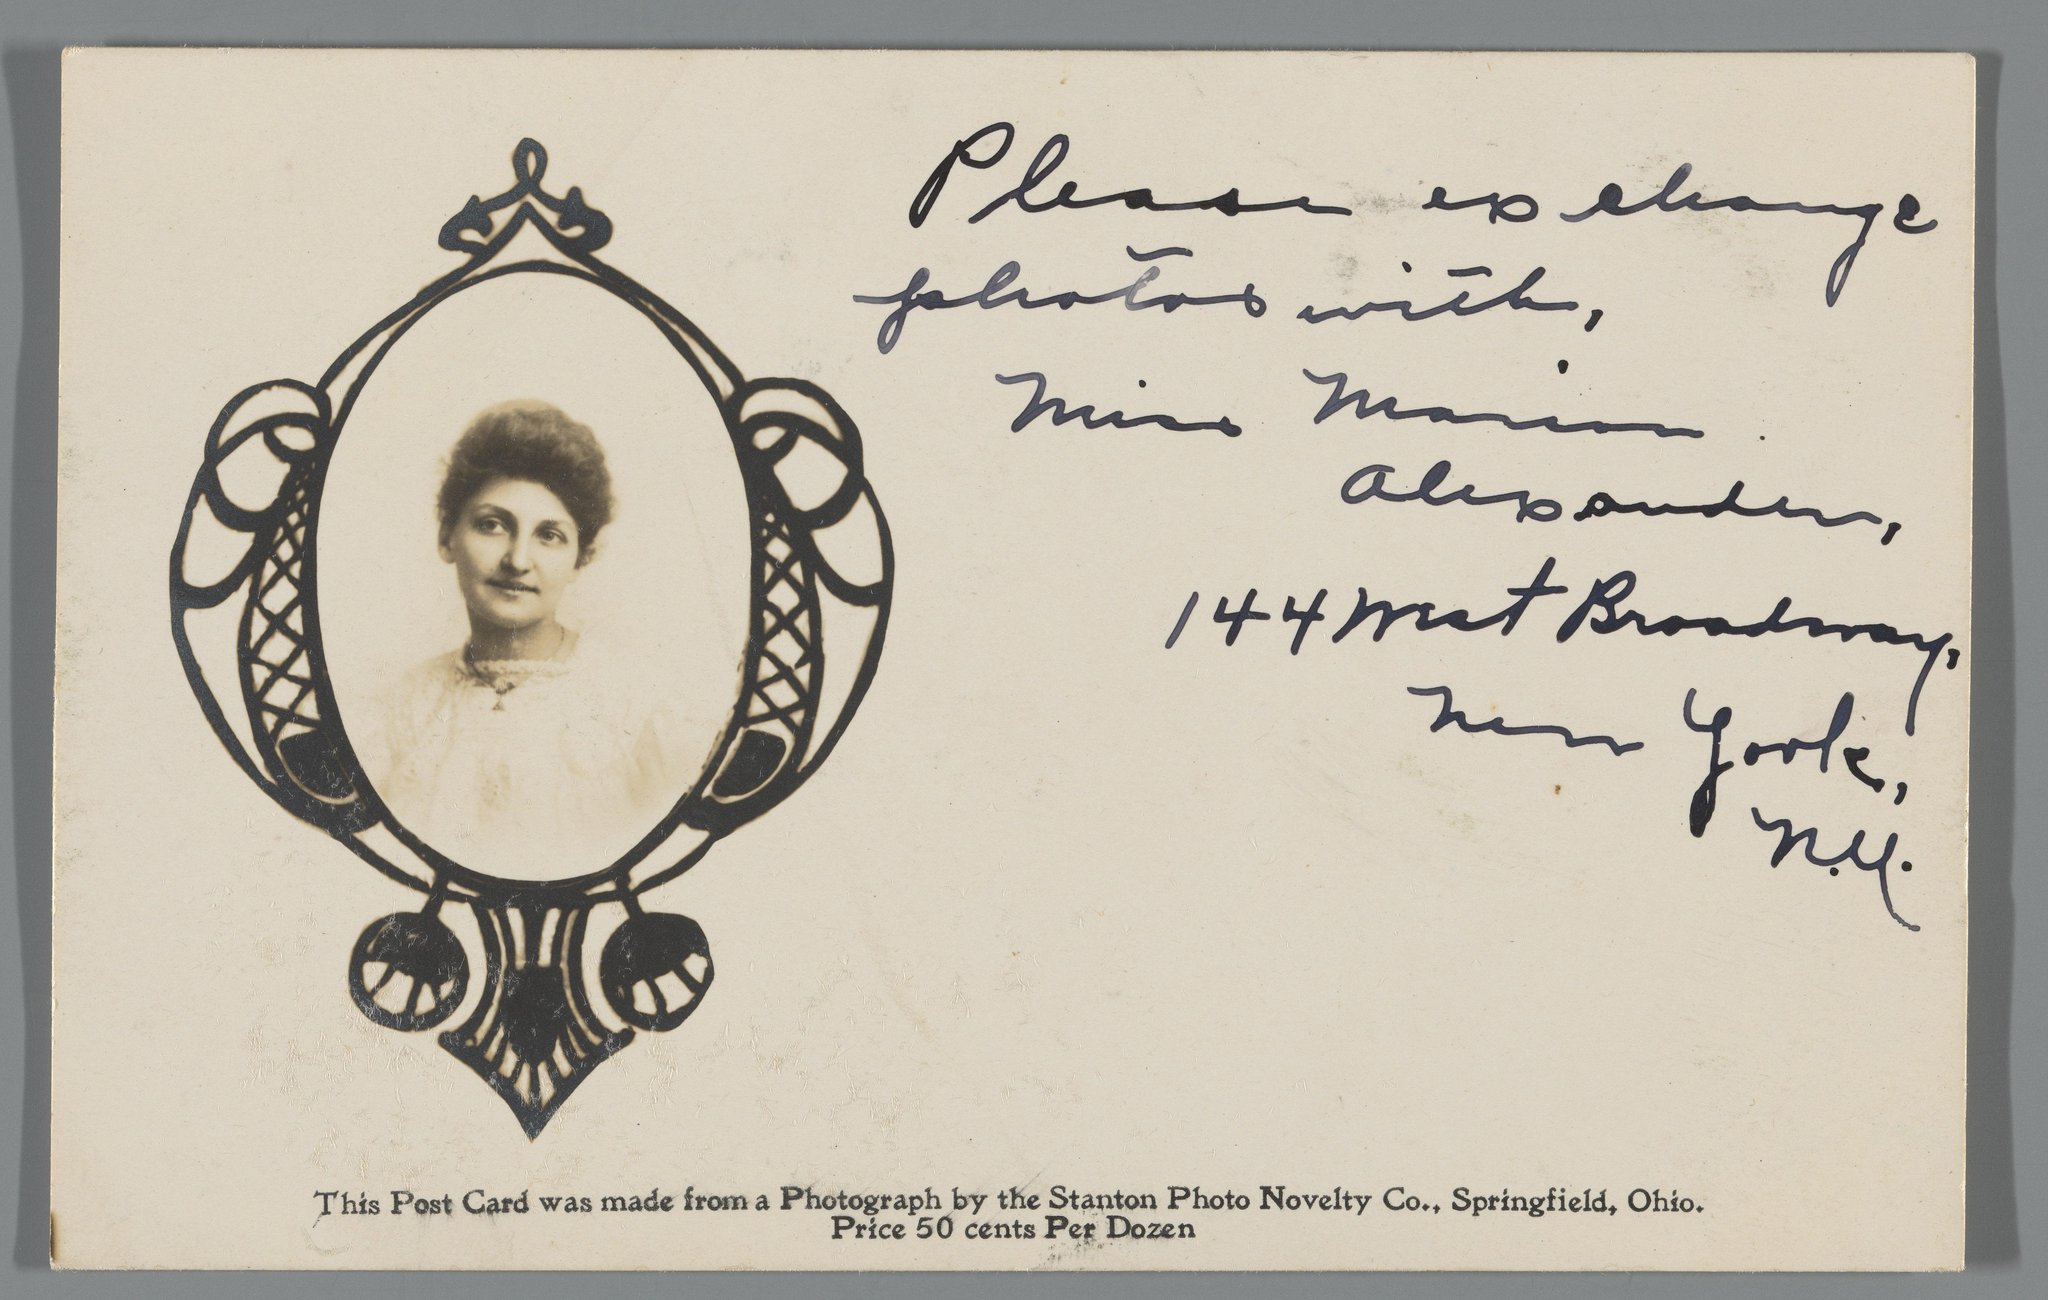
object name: ansichtkaart, prentbriefkaart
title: Reclame voor het uitwisselen van portretfoto’s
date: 1900-1920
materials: photographic support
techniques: gelatin silver print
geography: springfield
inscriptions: inscription: ‘[…] Beggs / Lexington / New York’, inscription: ‘Please exchange / photo with / Mina [?] Marion / Alexander, / 144 West Broadway, / New York, / N.Y. // This Post Card was made from a Photograph by the Stanton Photo Novelty Co., Springfield, Ohio. / Price 50 cents Per Dozen.’